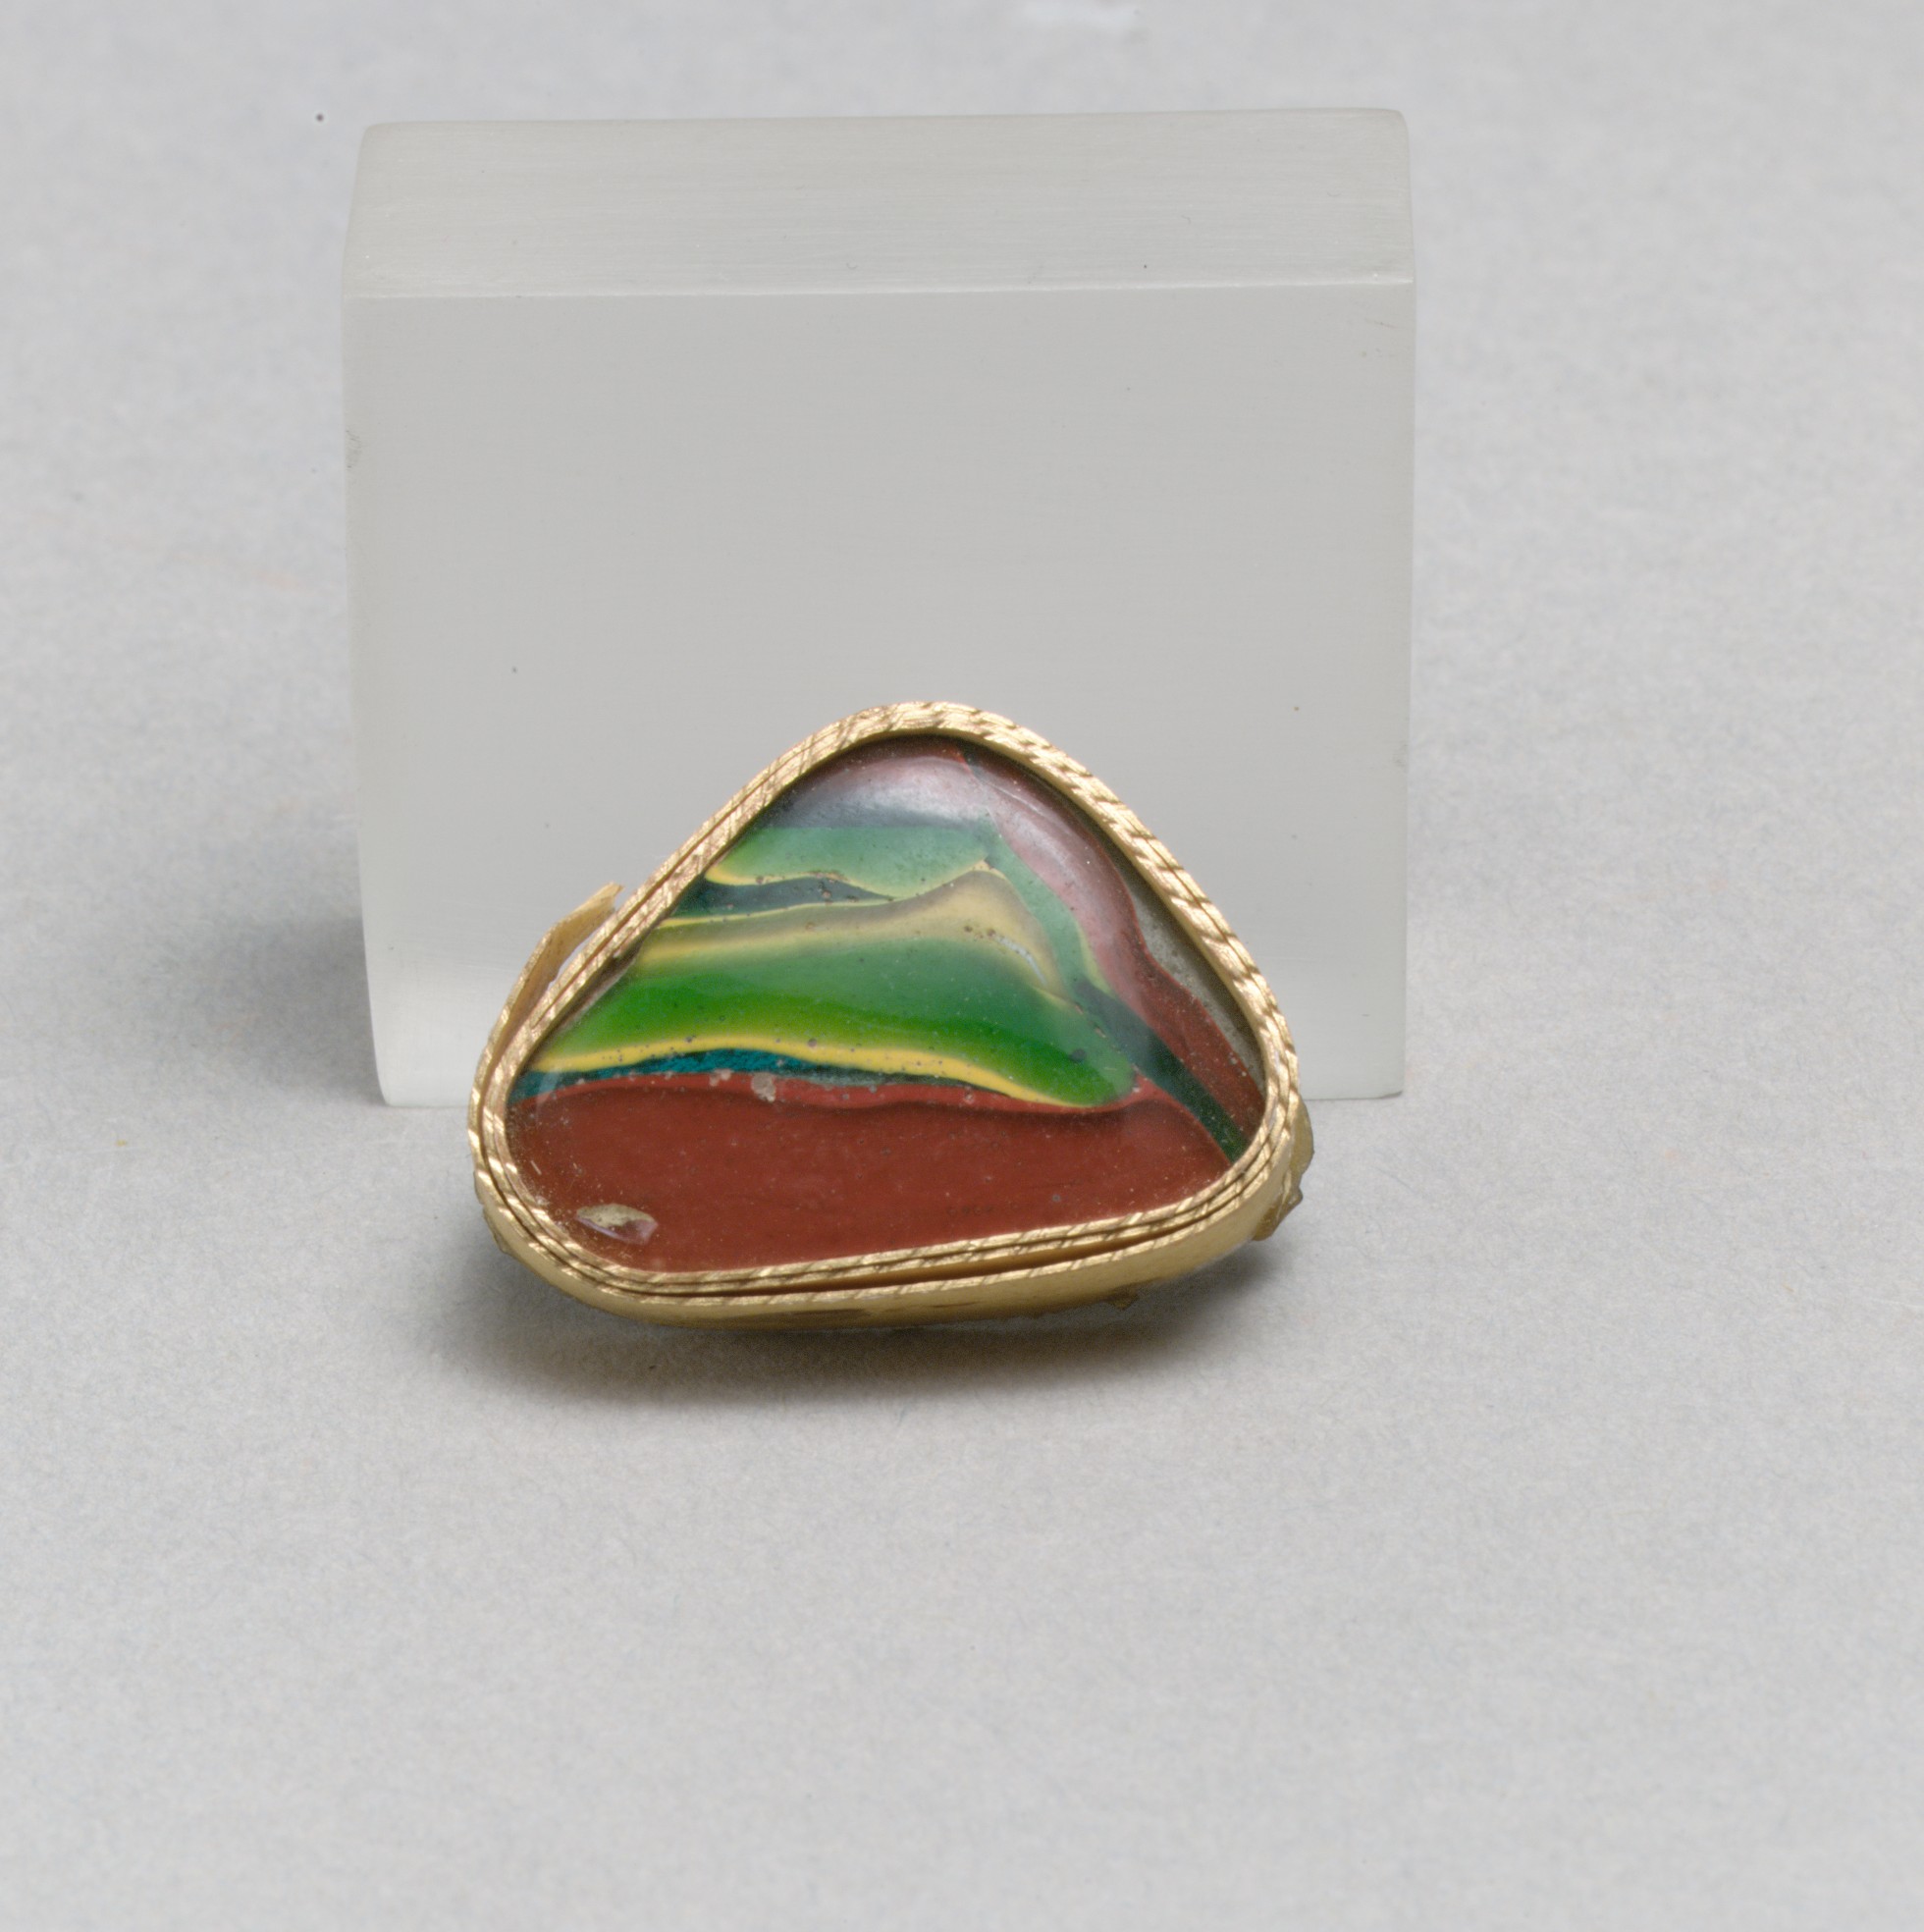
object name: fragment, mosaic bowl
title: Glass mosaic bowl fragment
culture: roman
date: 34 BCE-33 CE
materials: glass